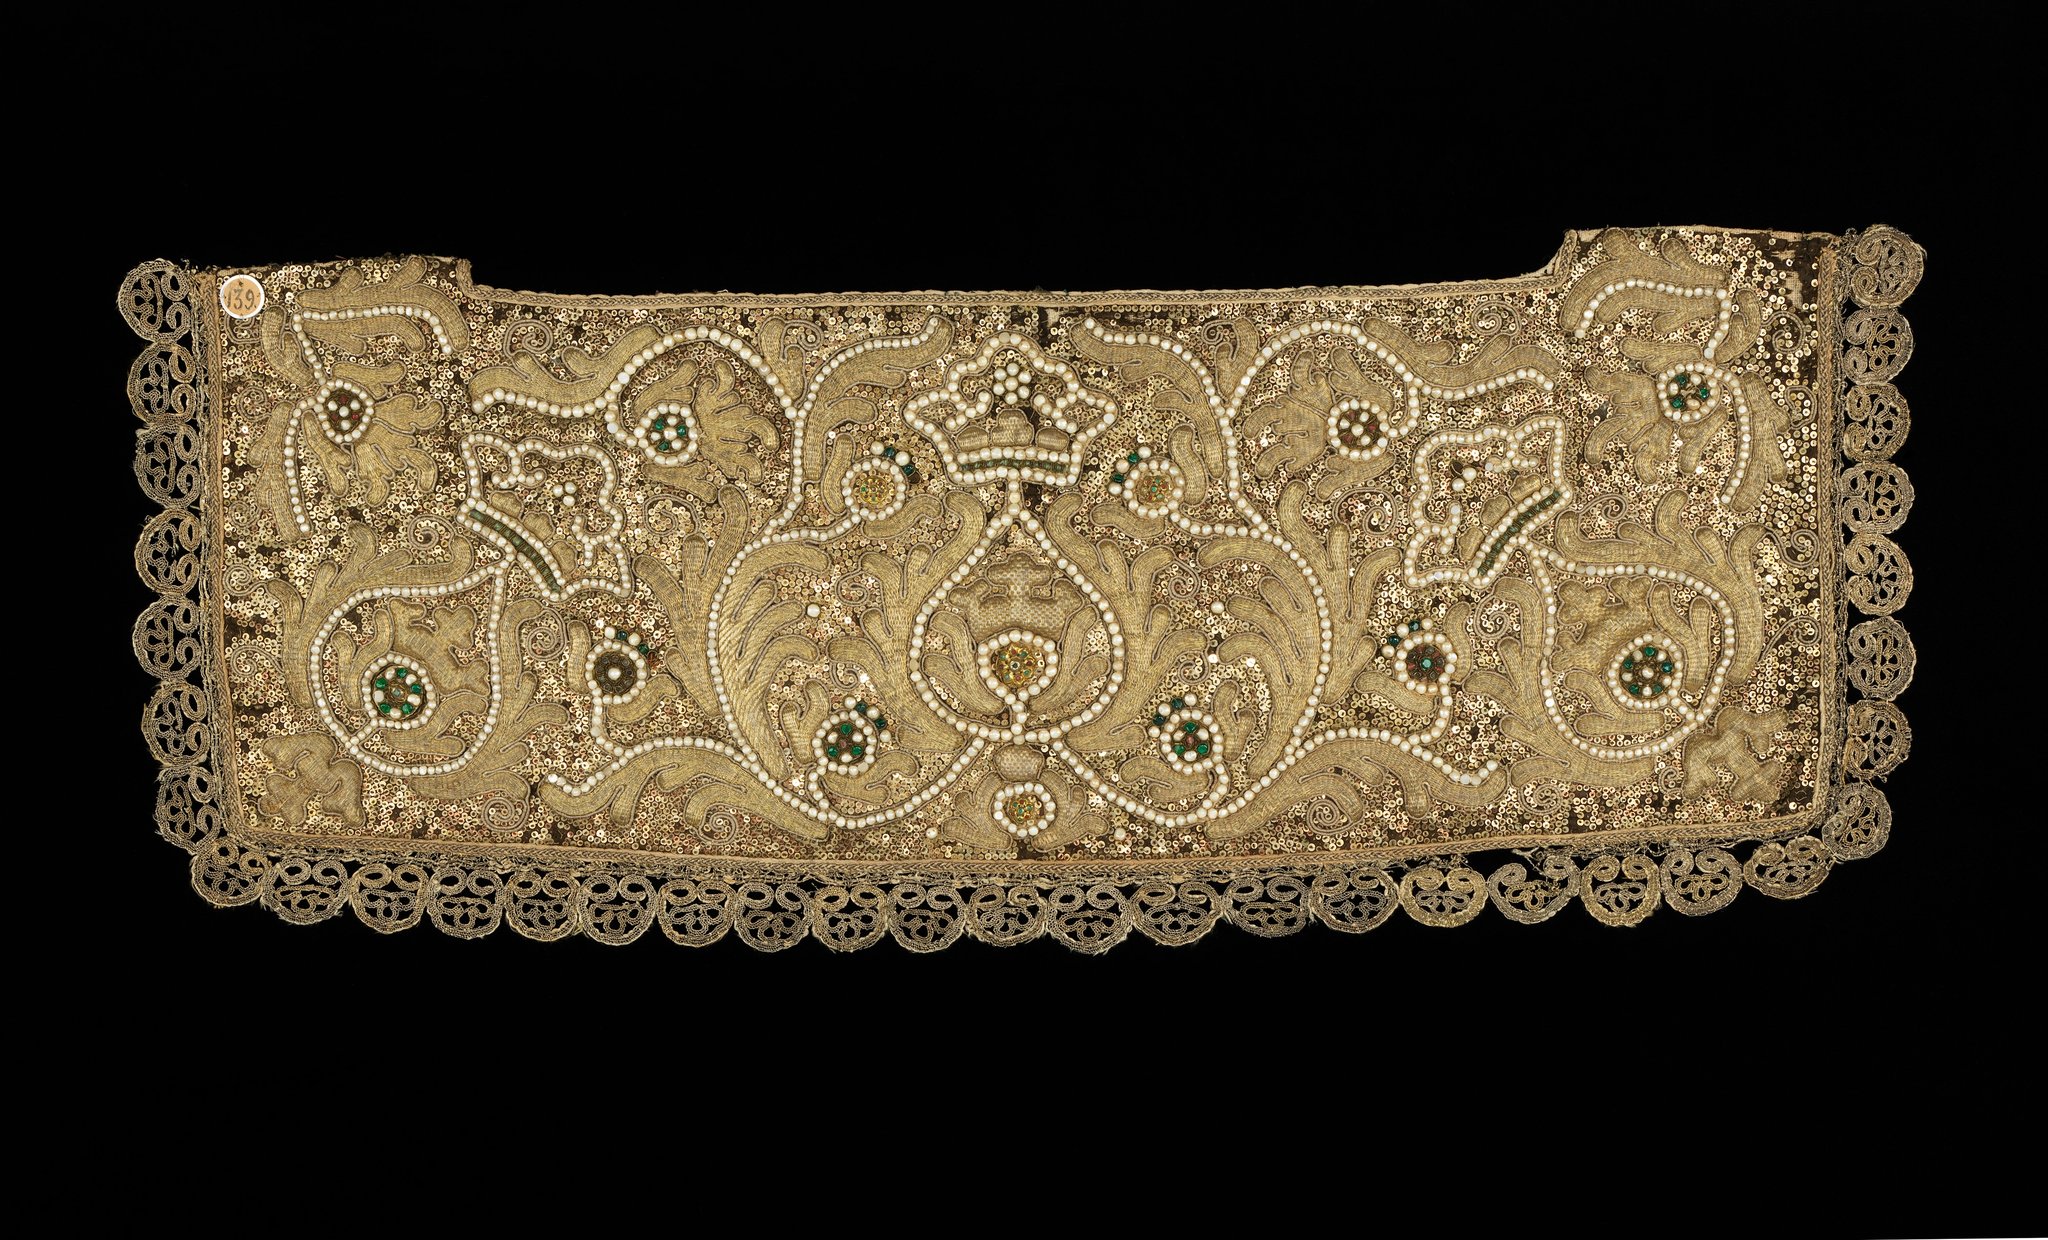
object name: vestment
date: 1675-1725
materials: linen, metal, mother of pearl, silk, stone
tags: crowns